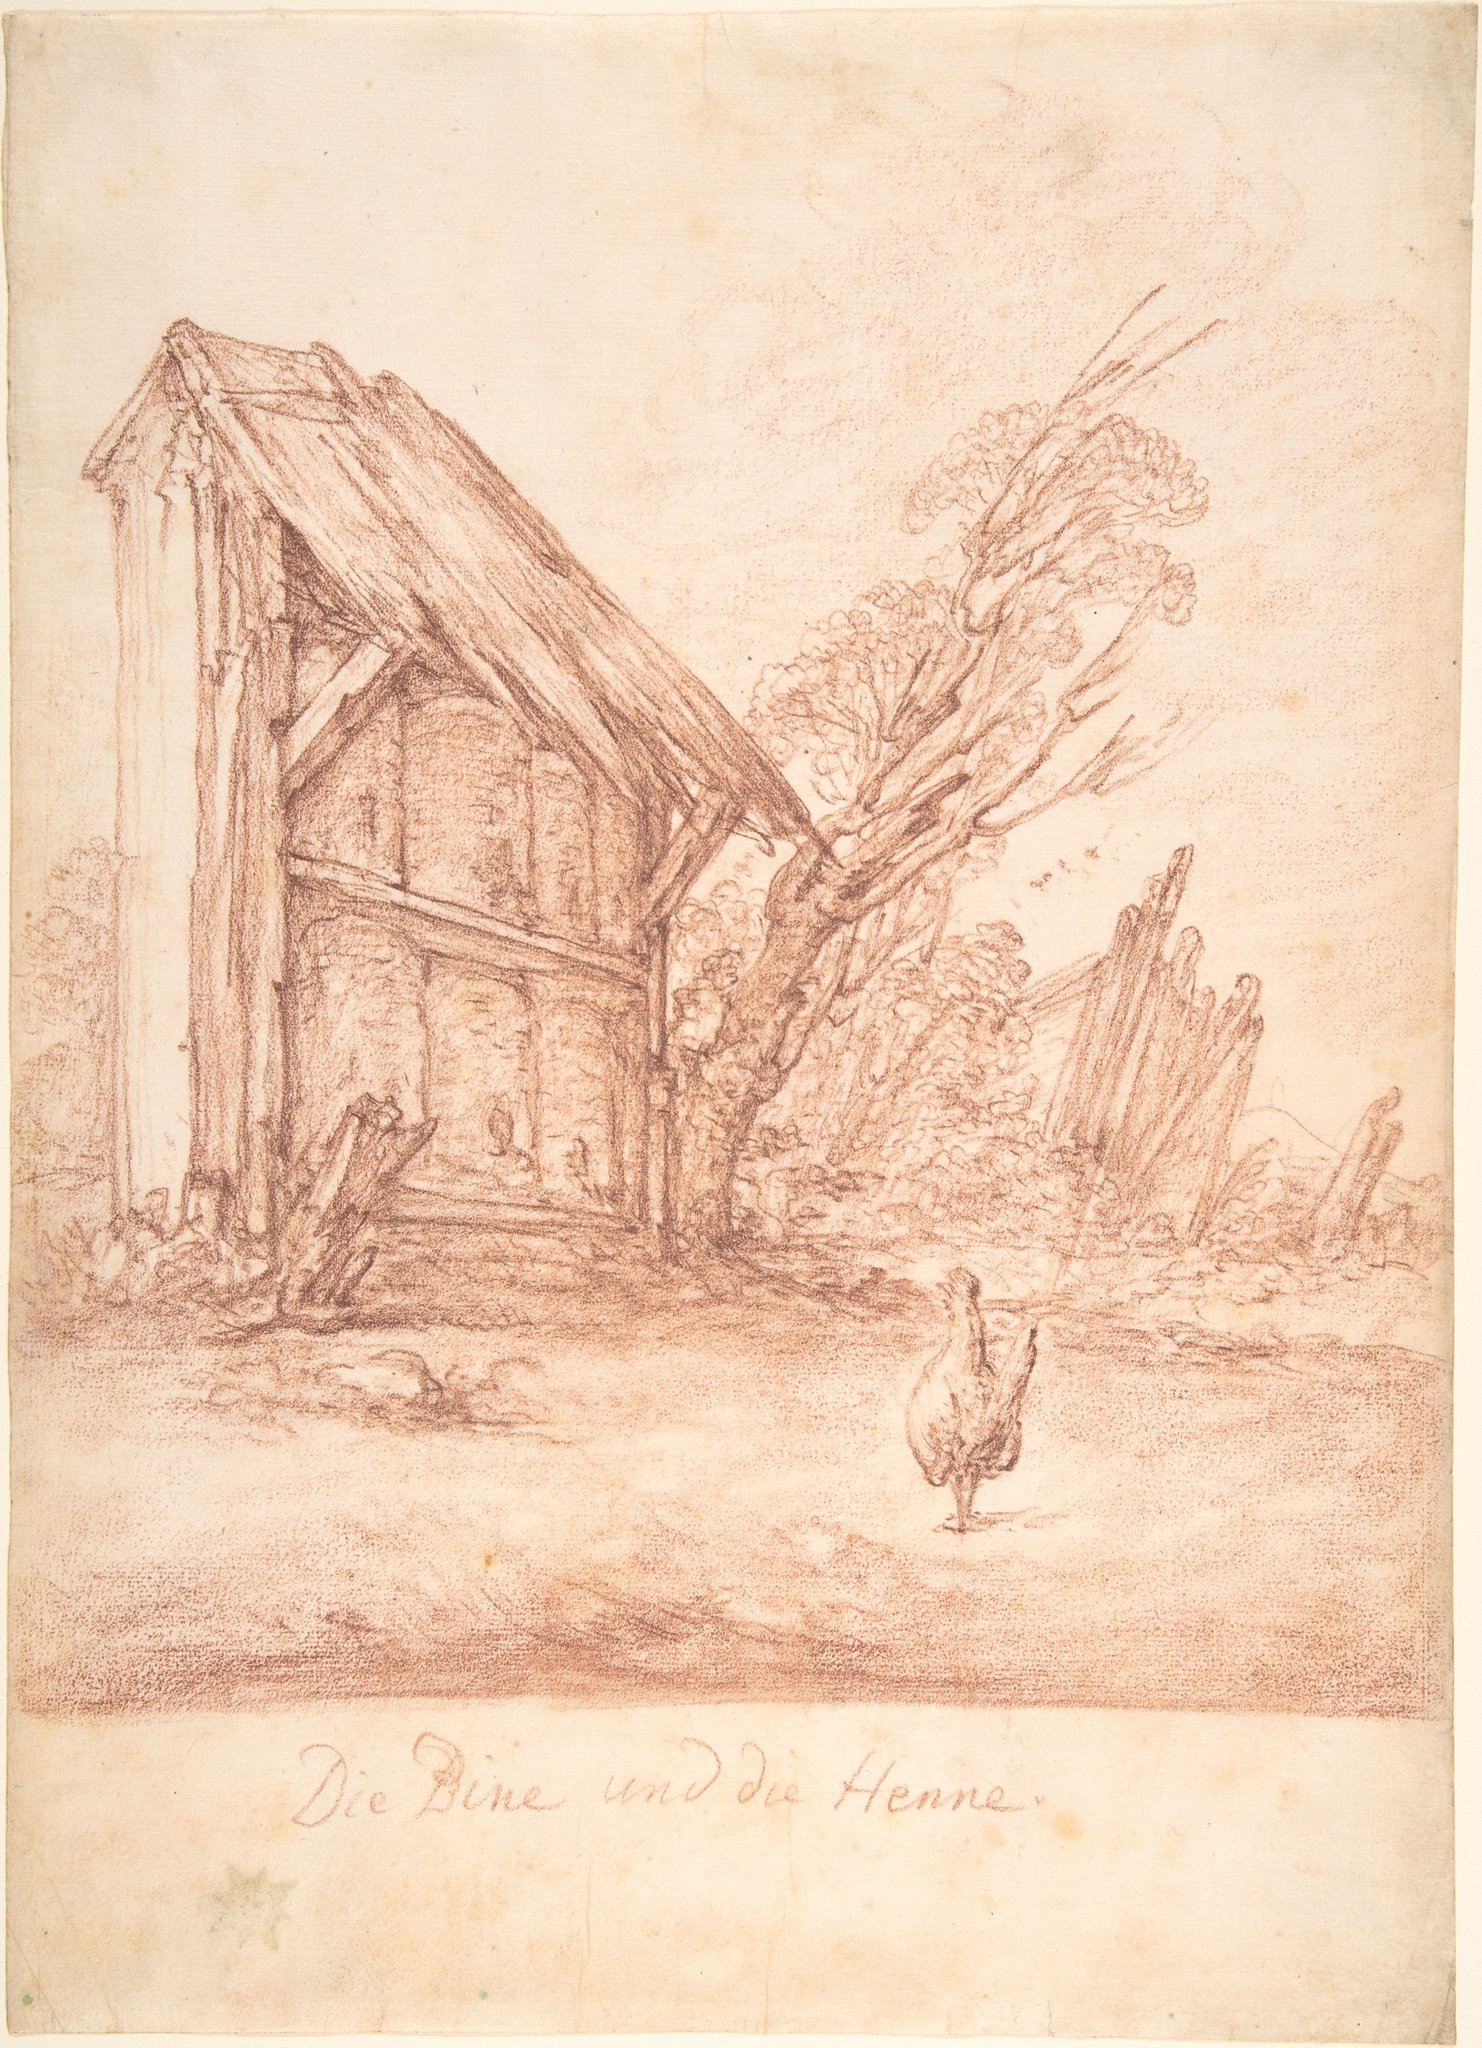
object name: drawing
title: The Bee and the Hen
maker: bernhard rode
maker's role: artist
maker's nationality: german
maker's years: 1725-1797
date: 1724-1797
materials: chalk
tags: chickens,bees